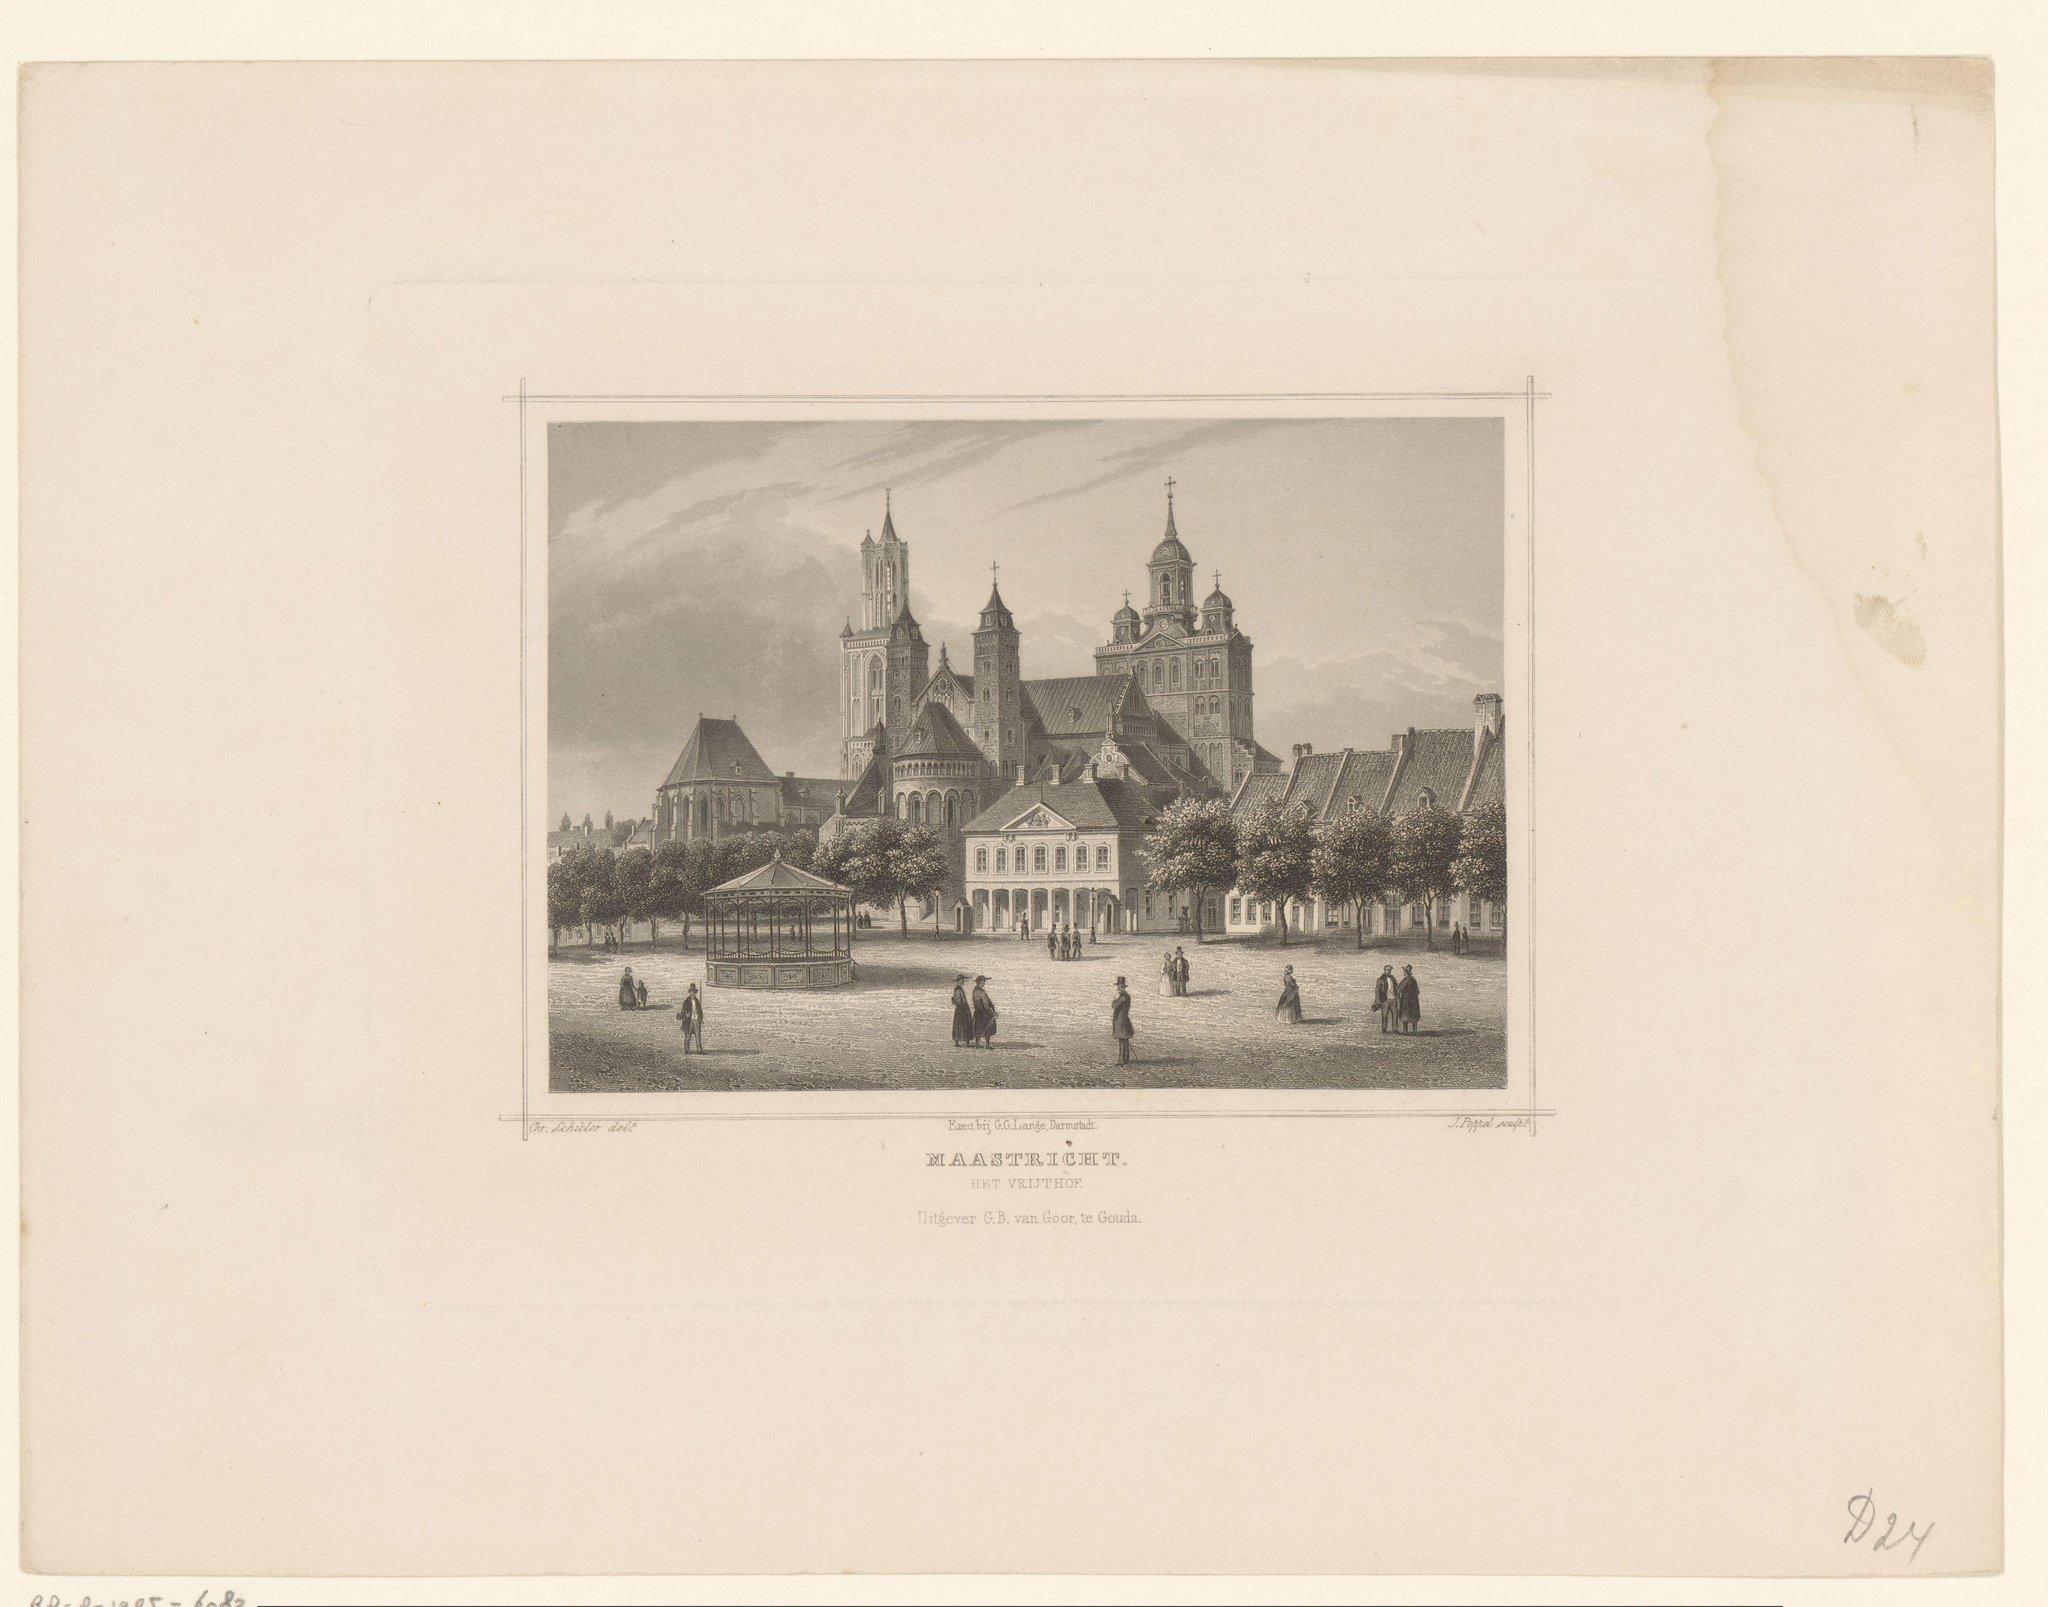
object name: print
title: Maastricht. Het Vrijthof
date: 1858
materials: paper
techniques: engraving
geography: gouda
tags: city-view, and landscape with man-made constructions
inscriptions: collector's mark: Lugt 2228, number: ‘D24’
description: Prent ook gebruikt in: Terwen, Johannes Leonardus. Het Koningrijk der Nederlanden voorgesteld in eene reeks van naar de natuur geteekende schilderachtige gezigten. Gouda: Van Goor, 1858-1862.